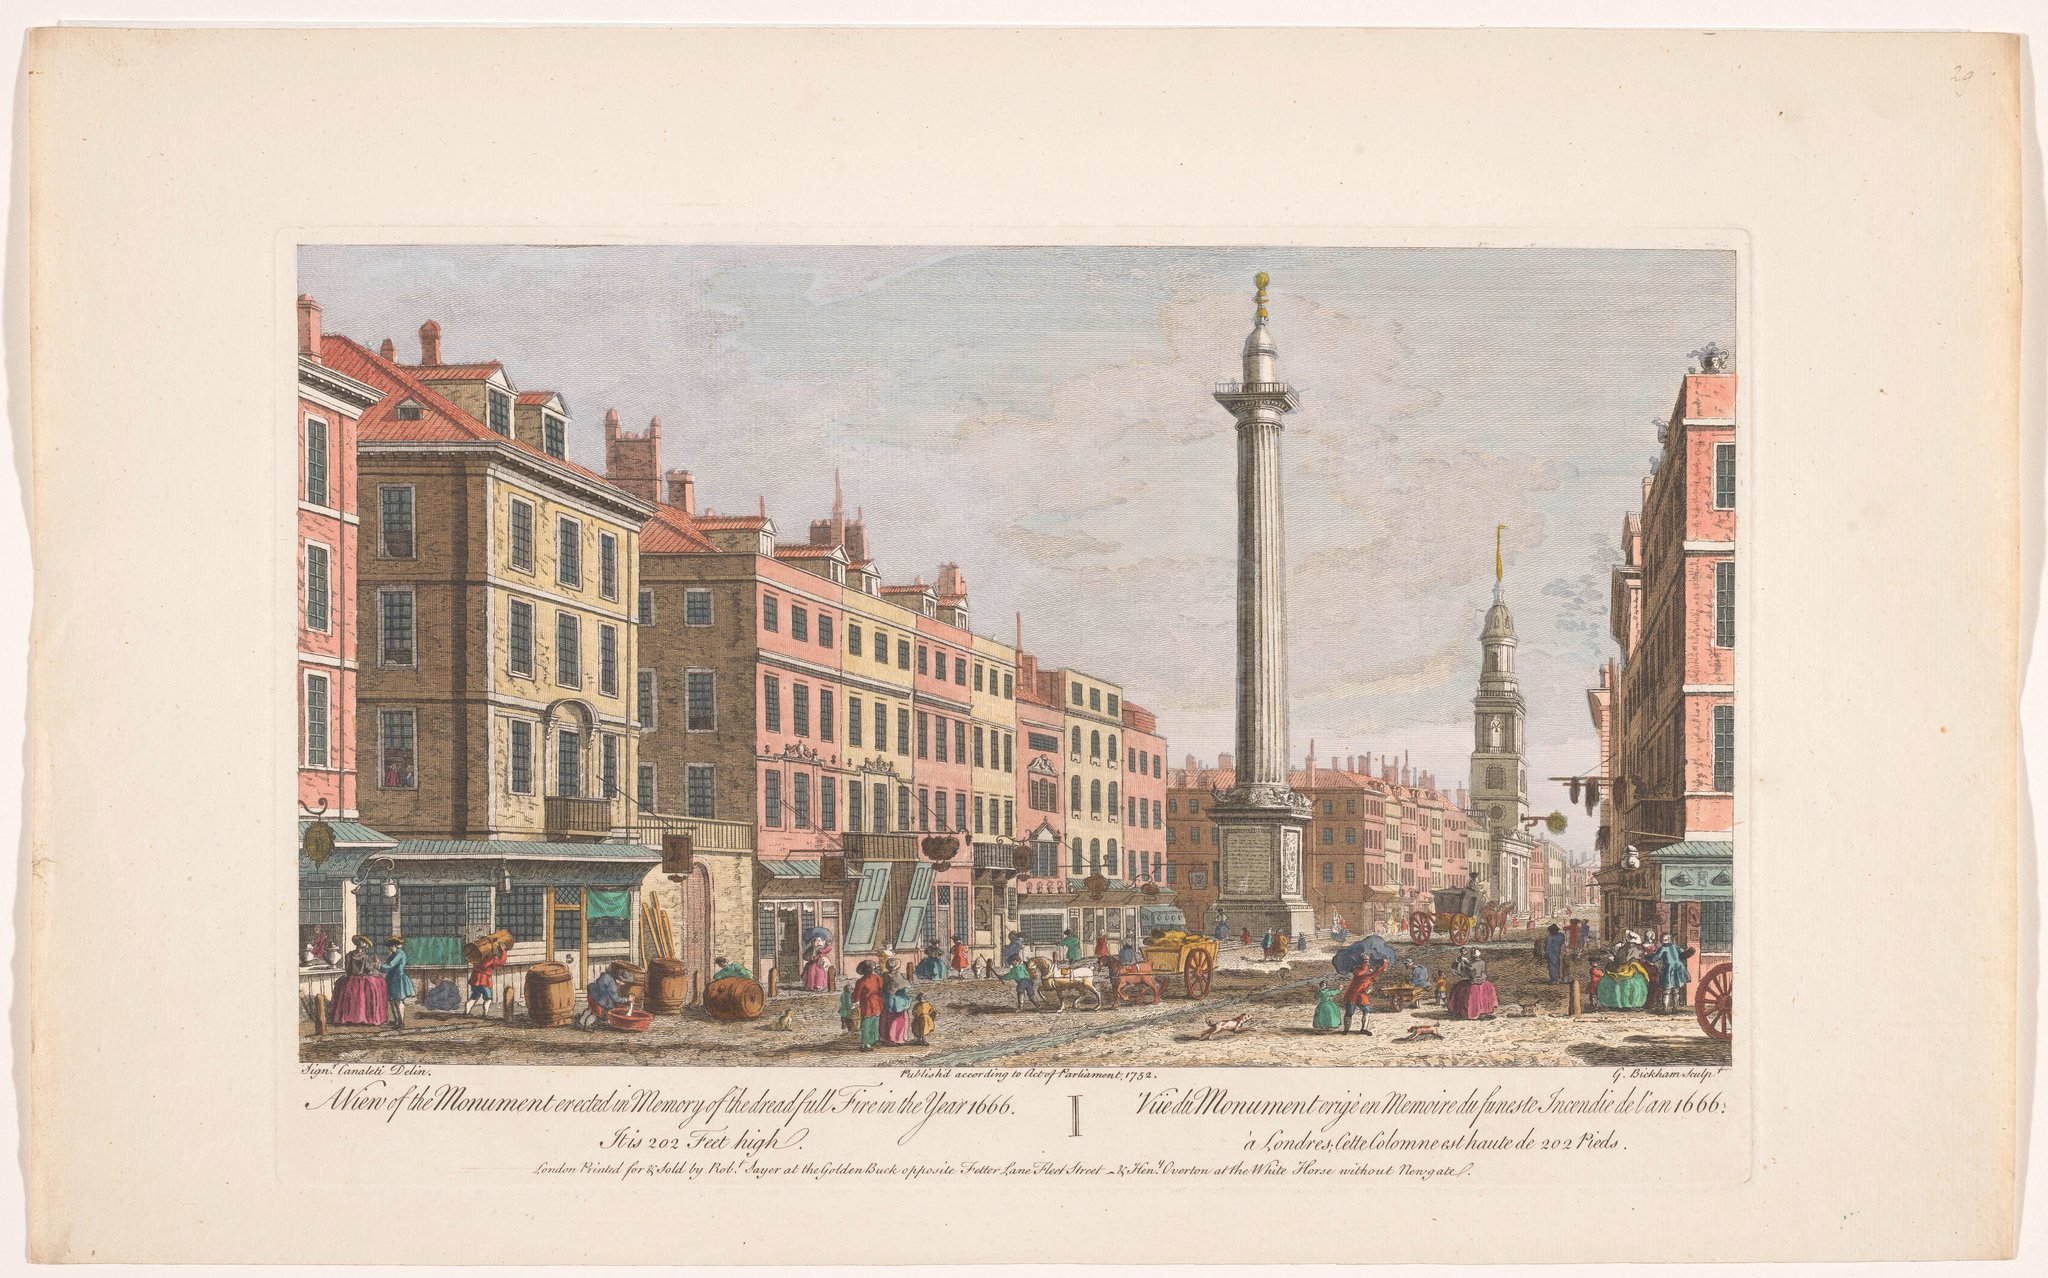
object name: print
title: Gezicht op het Monument to the Great Fire of London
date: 1752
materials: paper, watercolor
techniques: brush, etching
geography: london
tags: monument, statue, street (+ city(-scape) with figures, staffage)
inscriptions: date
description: De serie “Londen” bevat 52 prenten met de nummers 1-52, waarvan dit nummer 29 is.